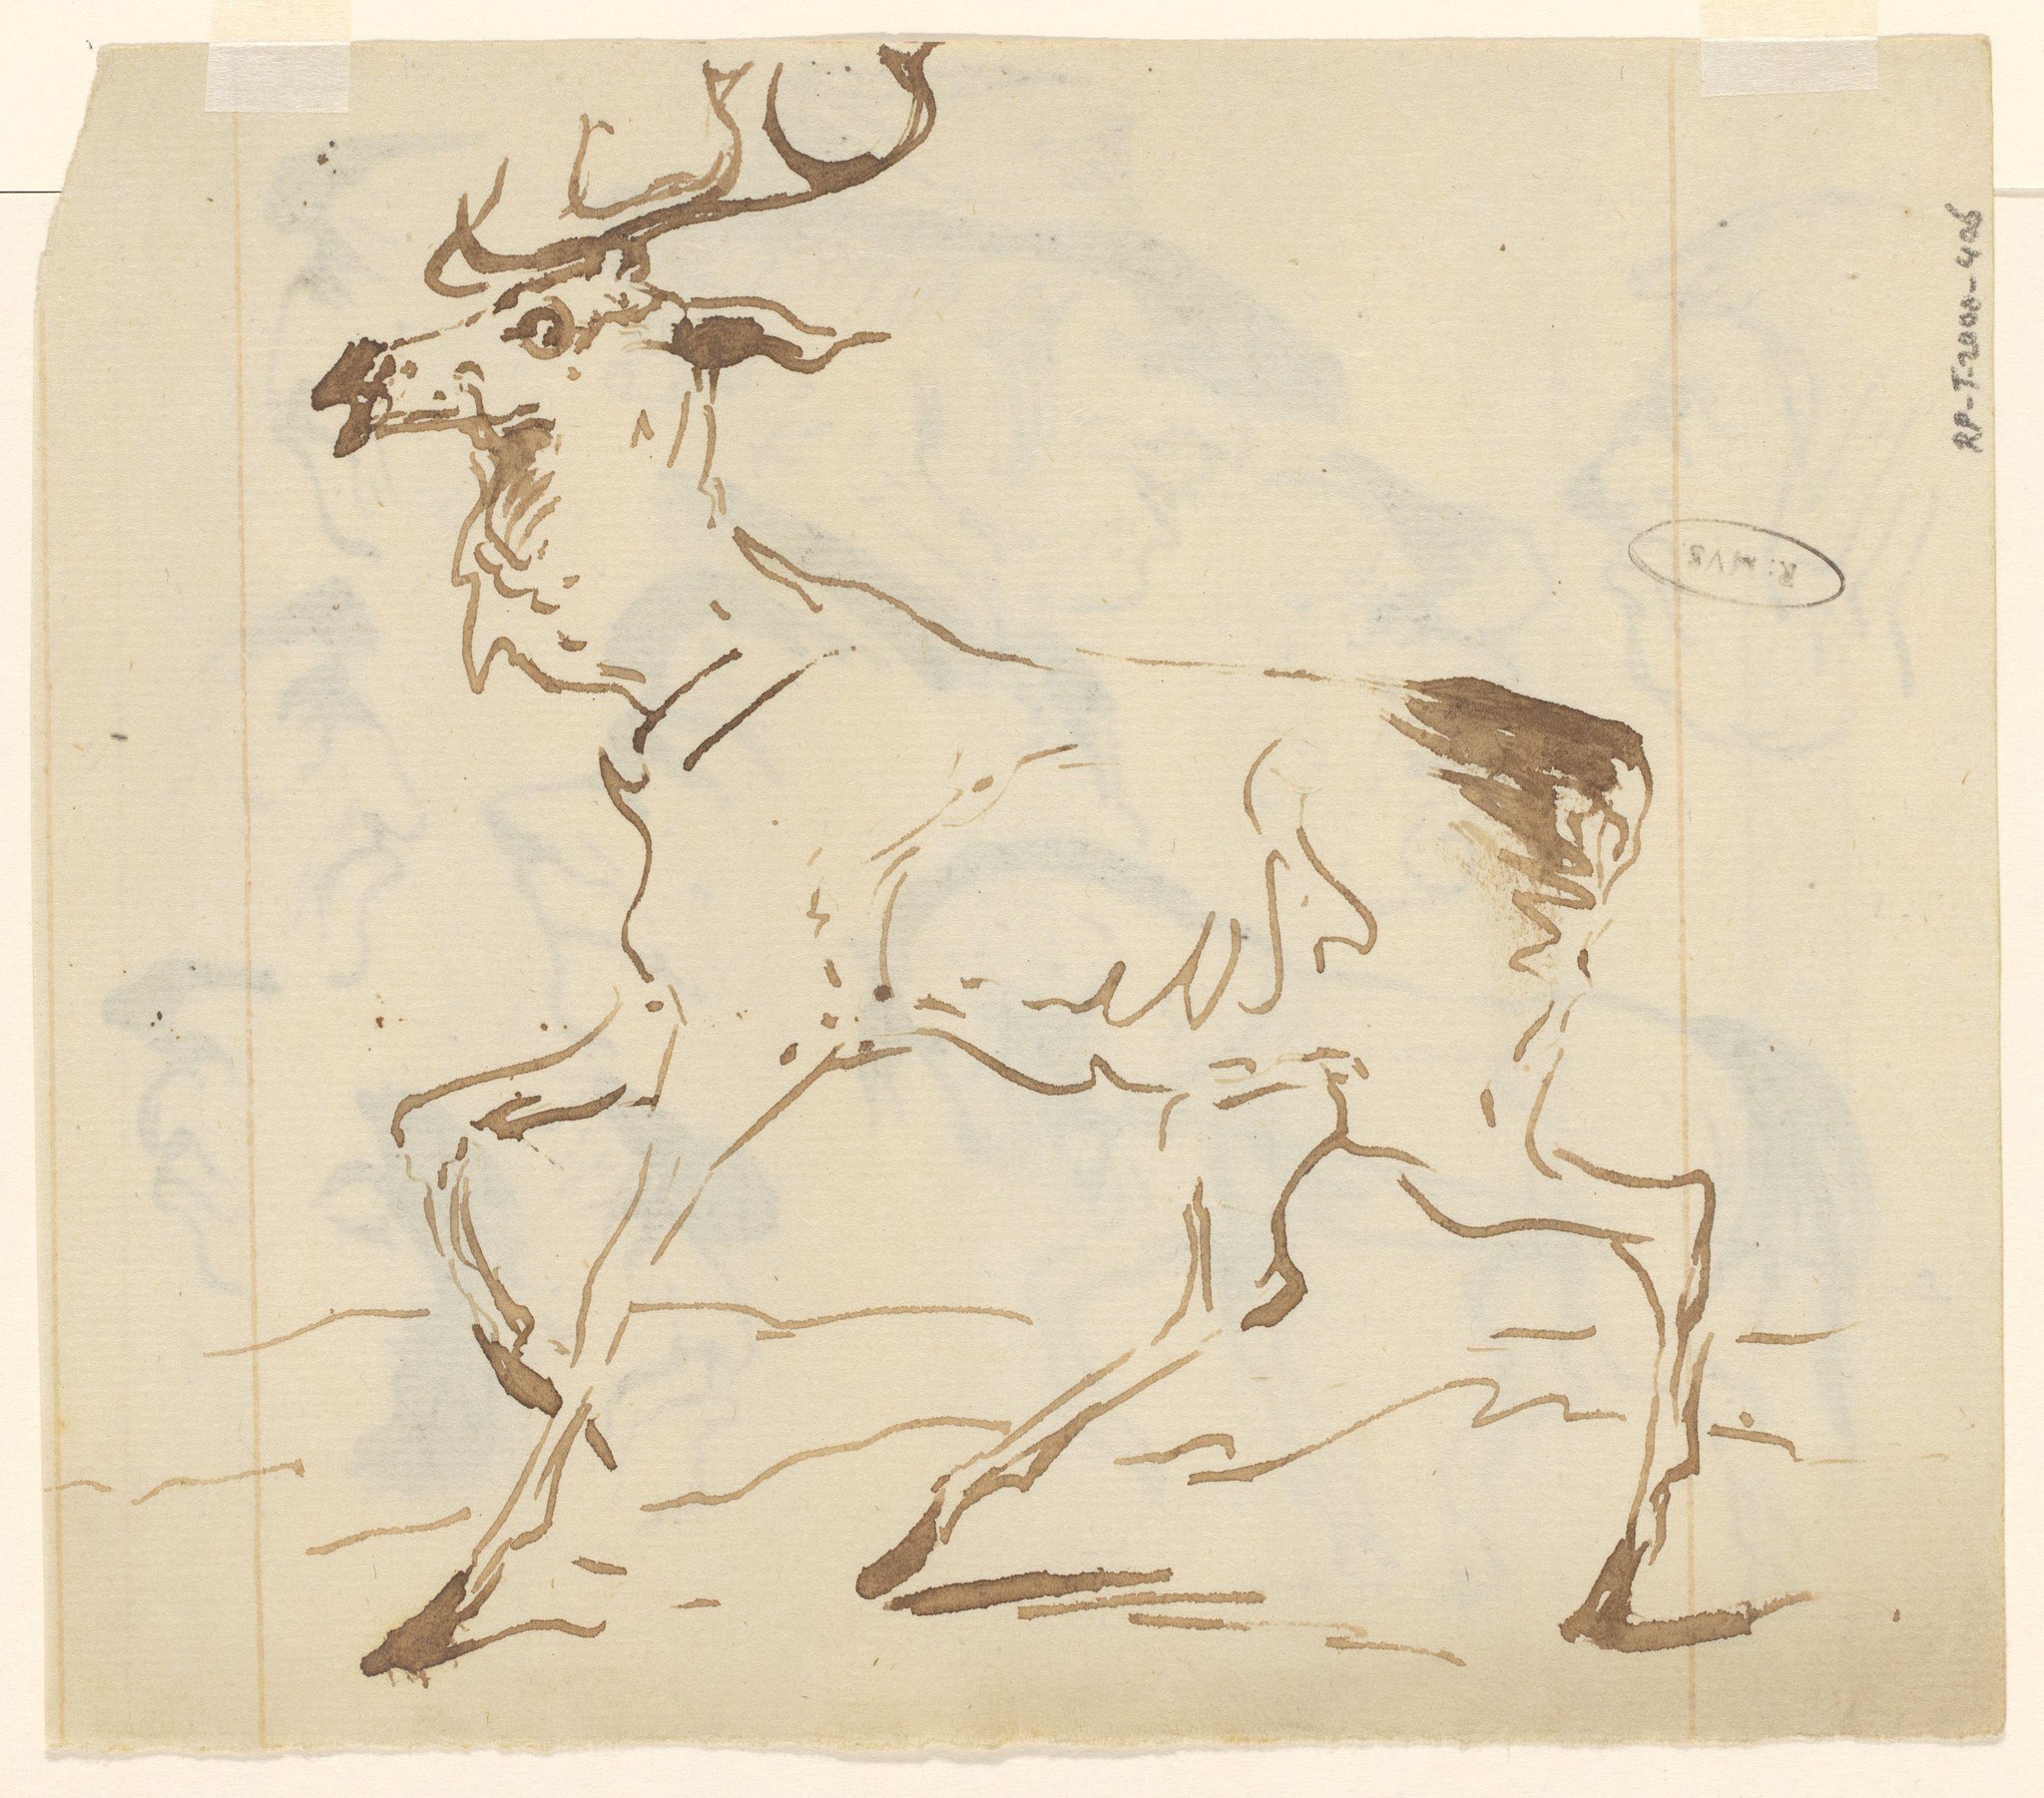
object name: drawing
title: Hert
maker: johannes tavenraat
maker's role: draughtsman, painter, print maker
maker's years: 1809-1881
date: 1840-1880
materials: ink, paper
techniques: pen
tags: hoofed animals: deer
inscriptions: collector's mark: Lugt 2228